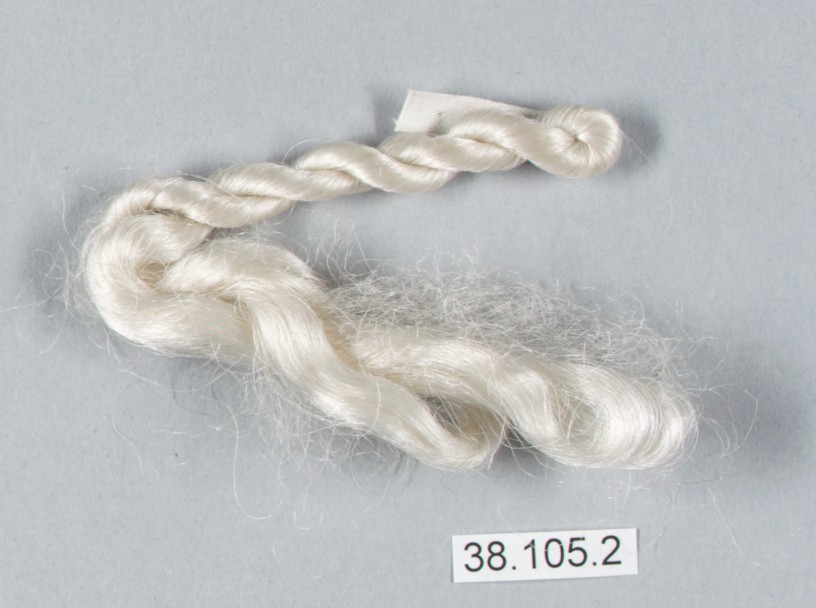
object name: skein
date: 1801-1900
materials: fiber